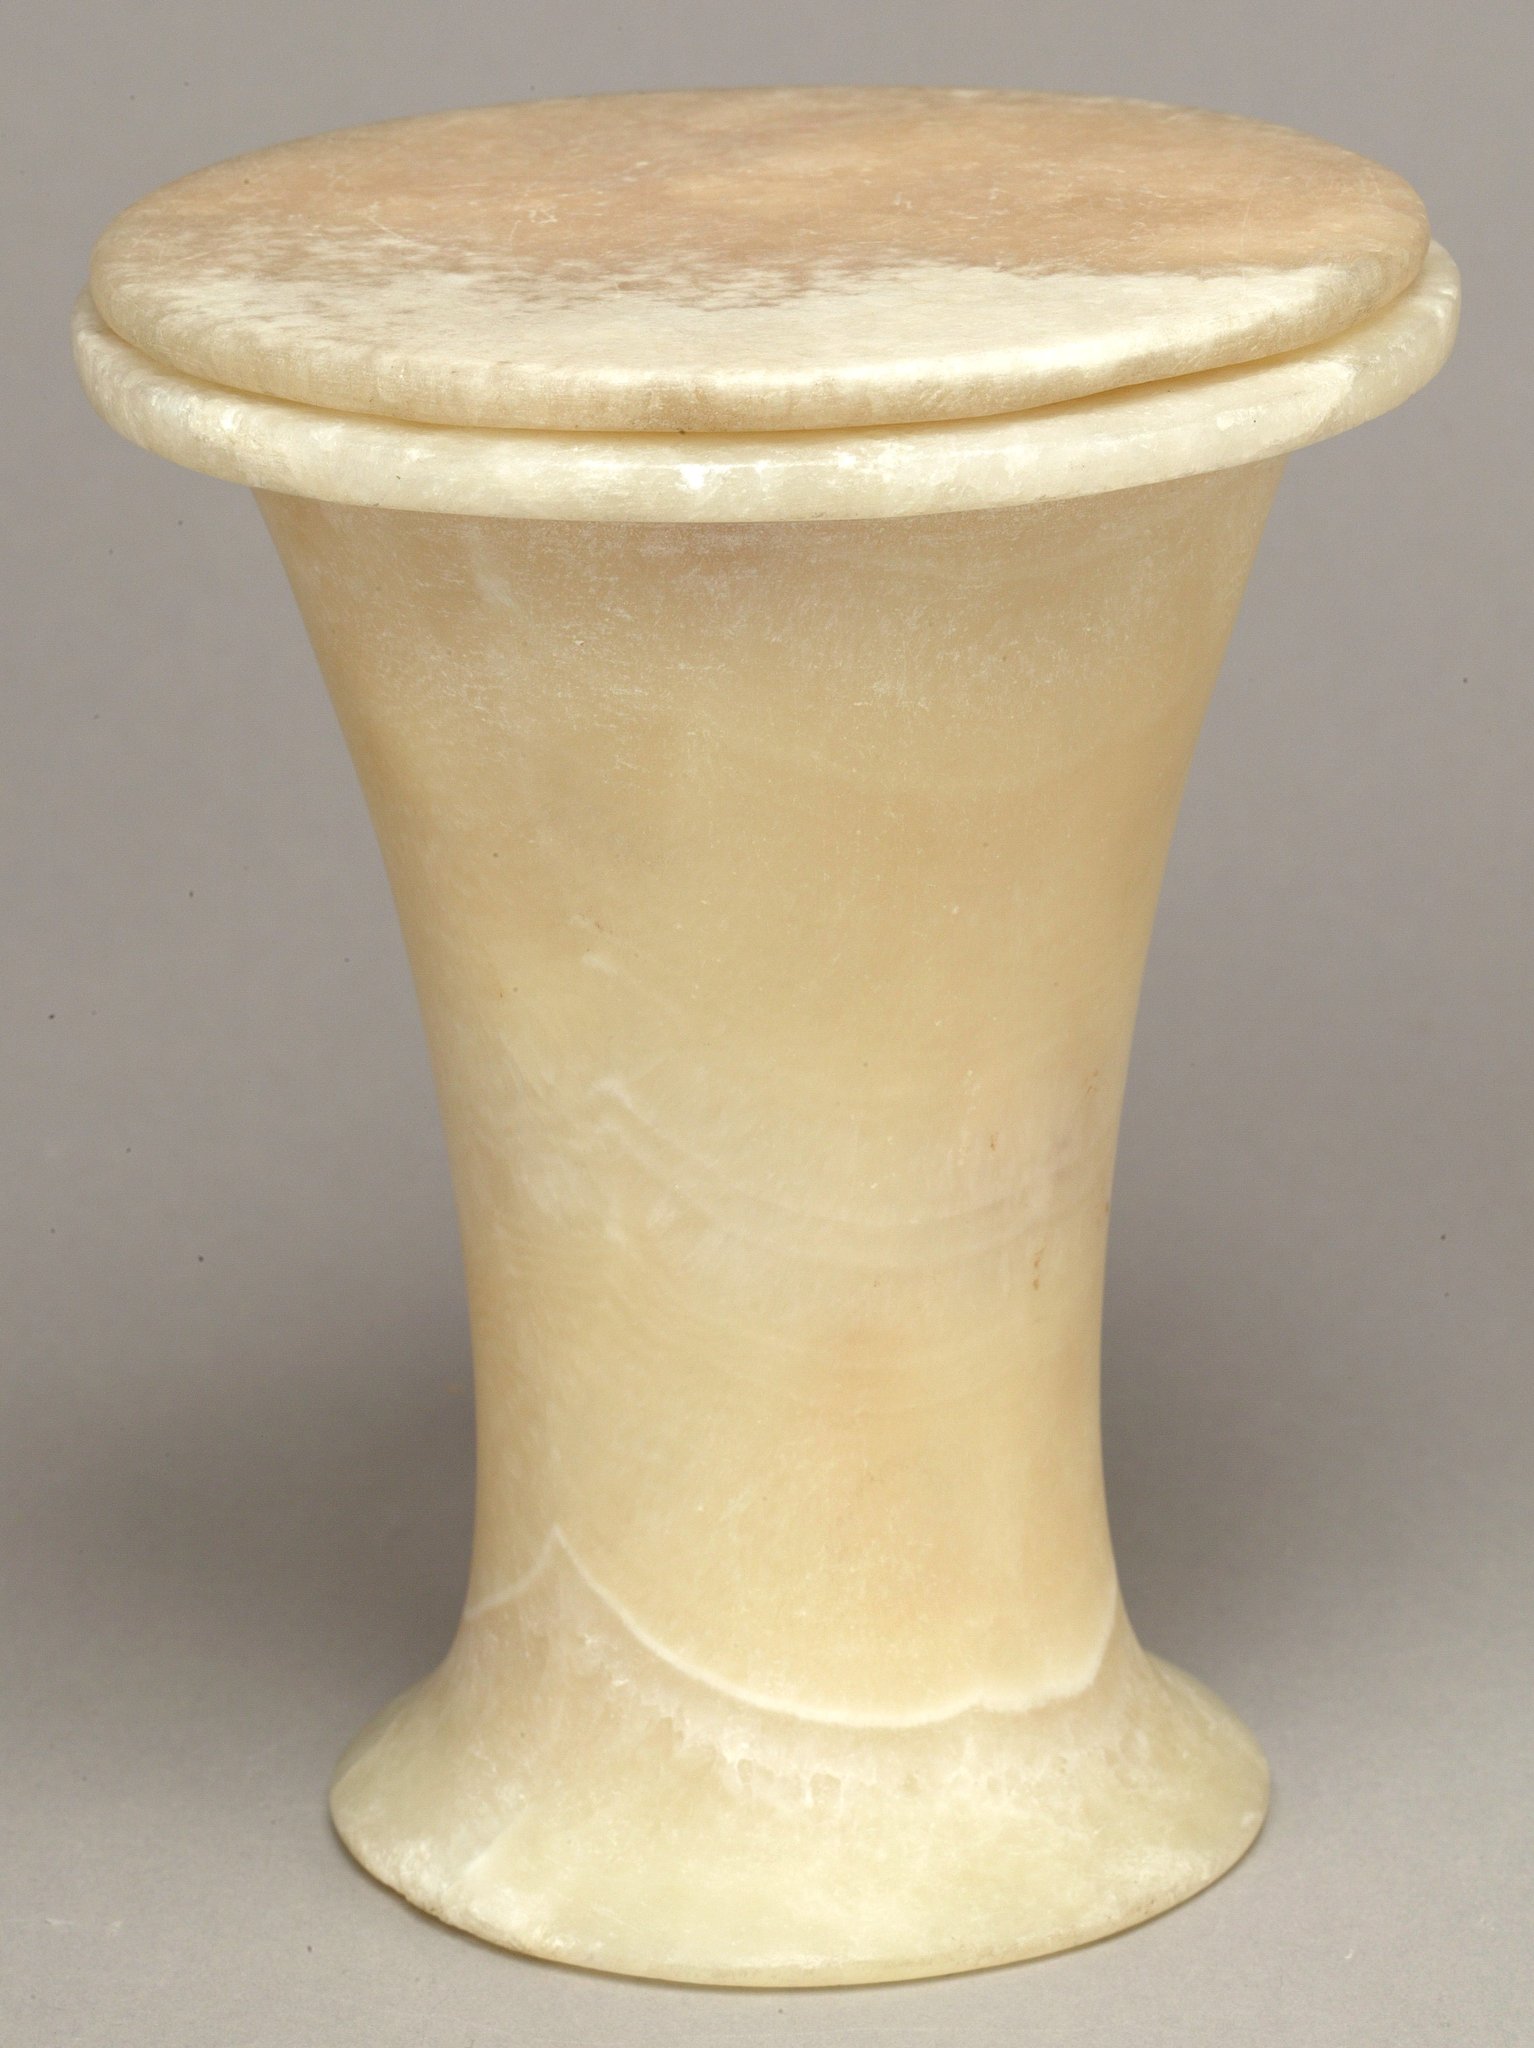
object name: ointment jar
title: Large Ointment Jar with Lid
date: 1479-1425 BCE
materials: stone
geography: upper egypt, thebes